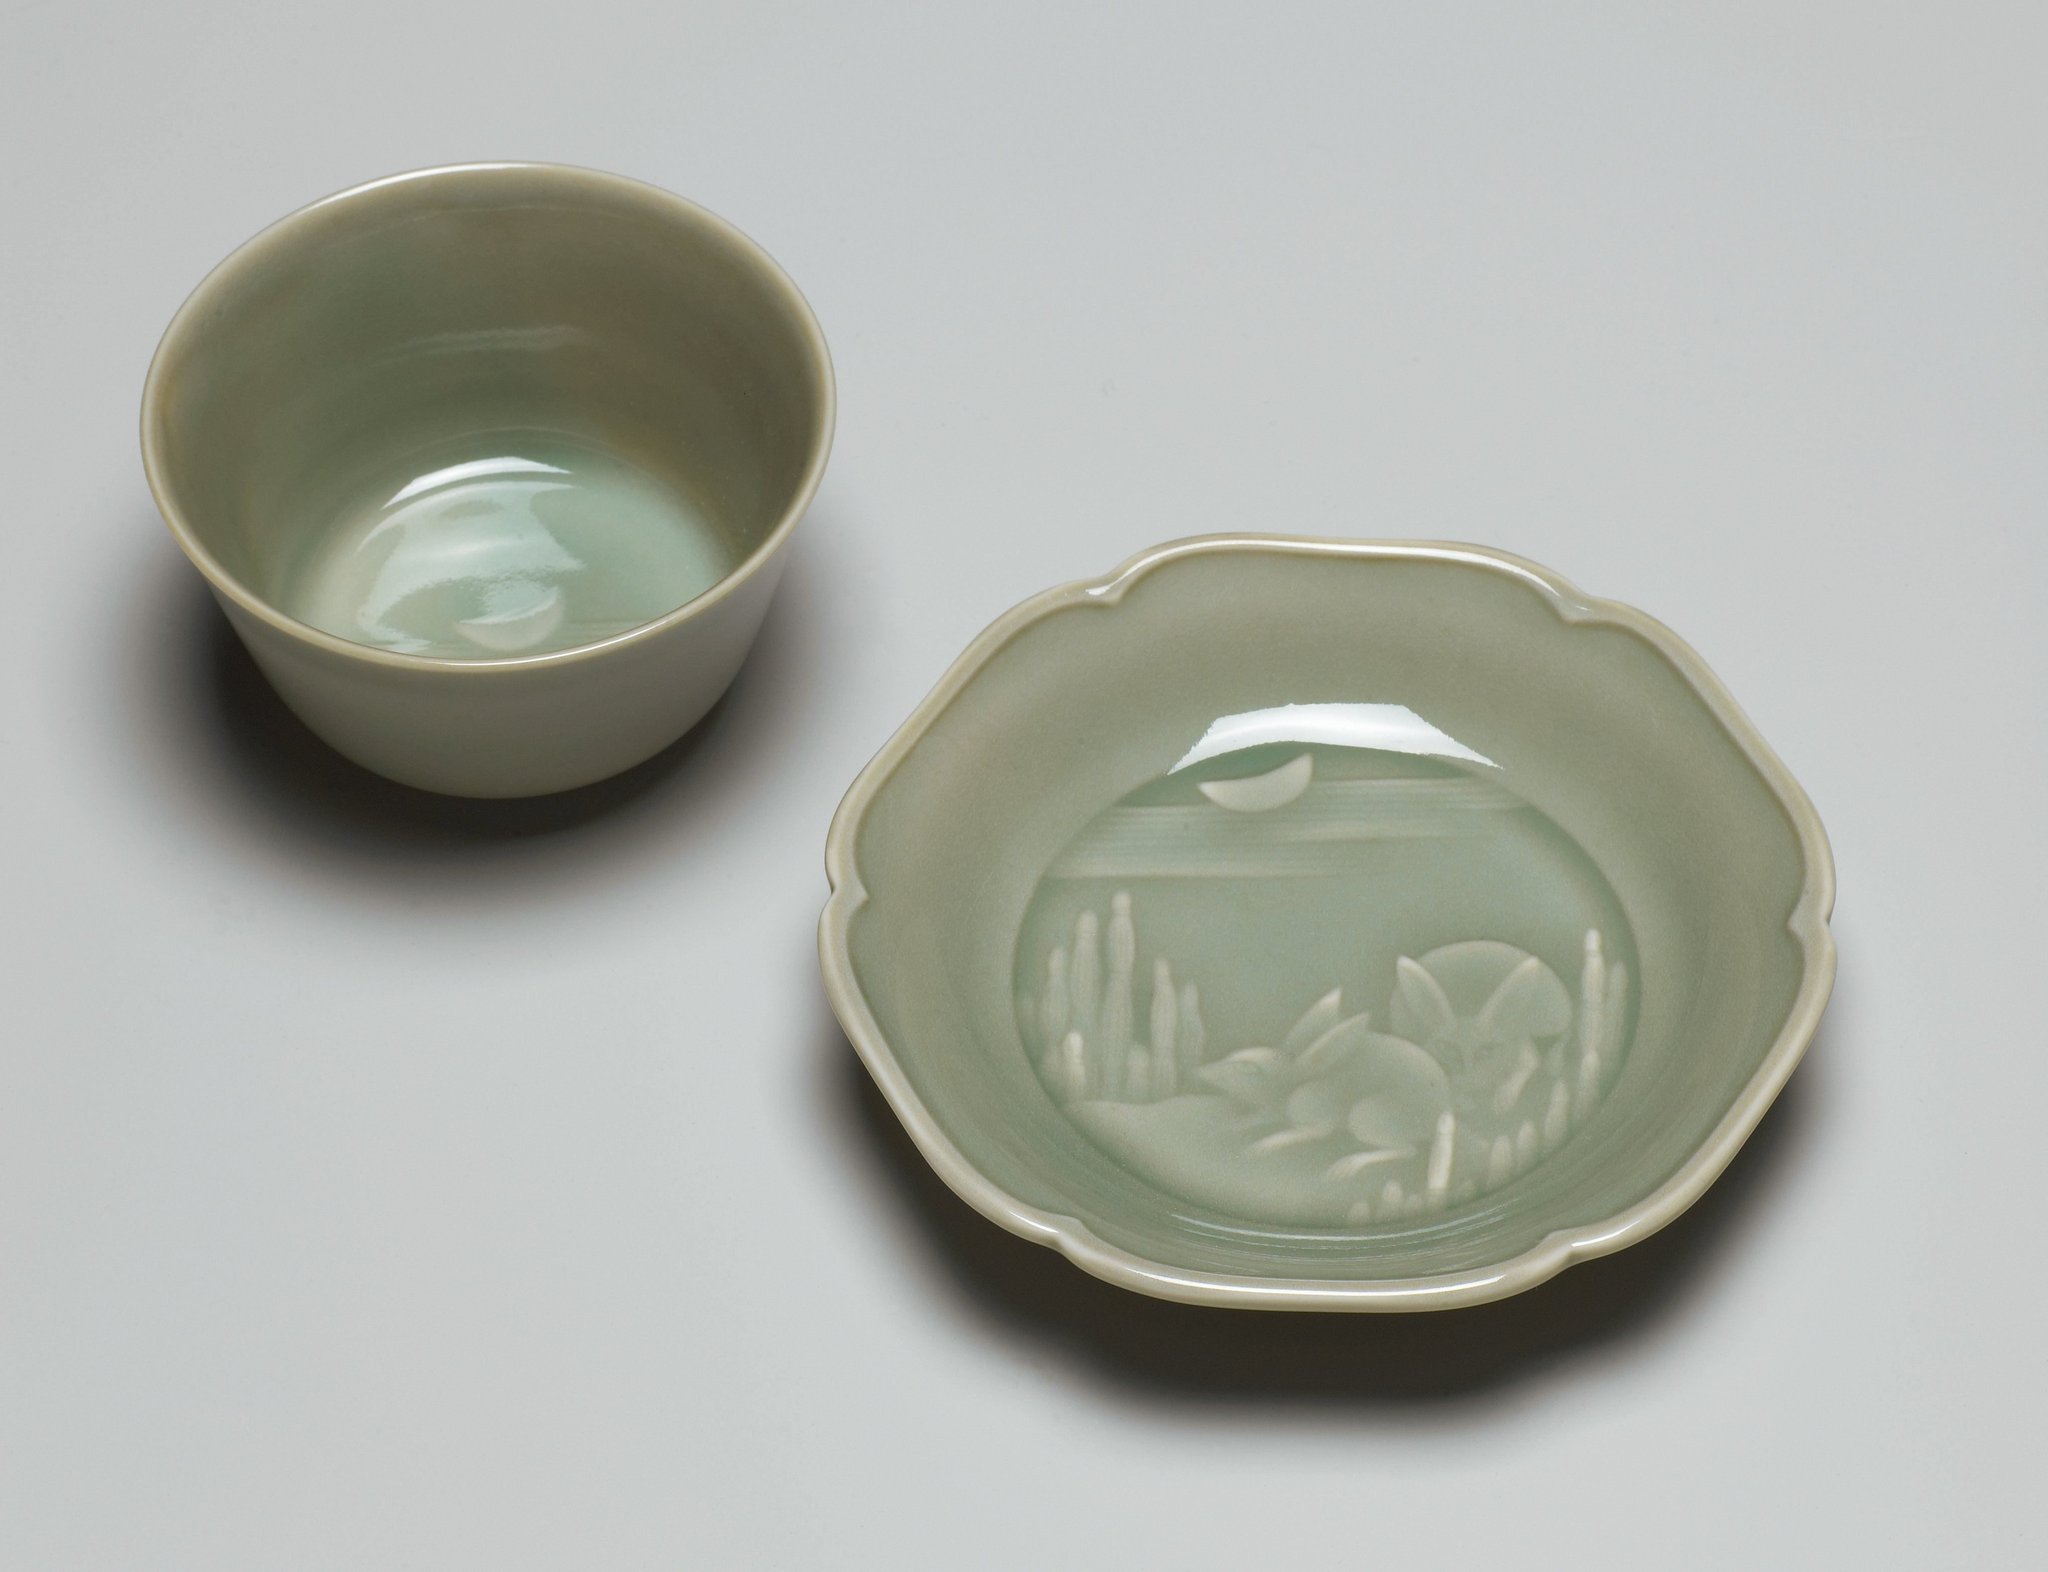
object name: kop en schotel, kop en schotel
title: Bell-shaped cup and saucer with two hares and the moon in relief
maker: masato imaizumi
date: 2002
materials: glaze, porcelain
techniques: firing, relief, turning, vitrification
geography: japan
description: Klokvormige kop en een geschulpte schotel van porselein, bedekt met een transparant glazuur met een lichtblauwe tint. Op het plat van de schotel in reliëf twee hazen in een landschap onder de maan tussen wolken. Op de bodem van de kop alleen de maan tussen wolken. Gemerkt op de onderzijde. Qingbai-kleurig glazuur. Monochromen.